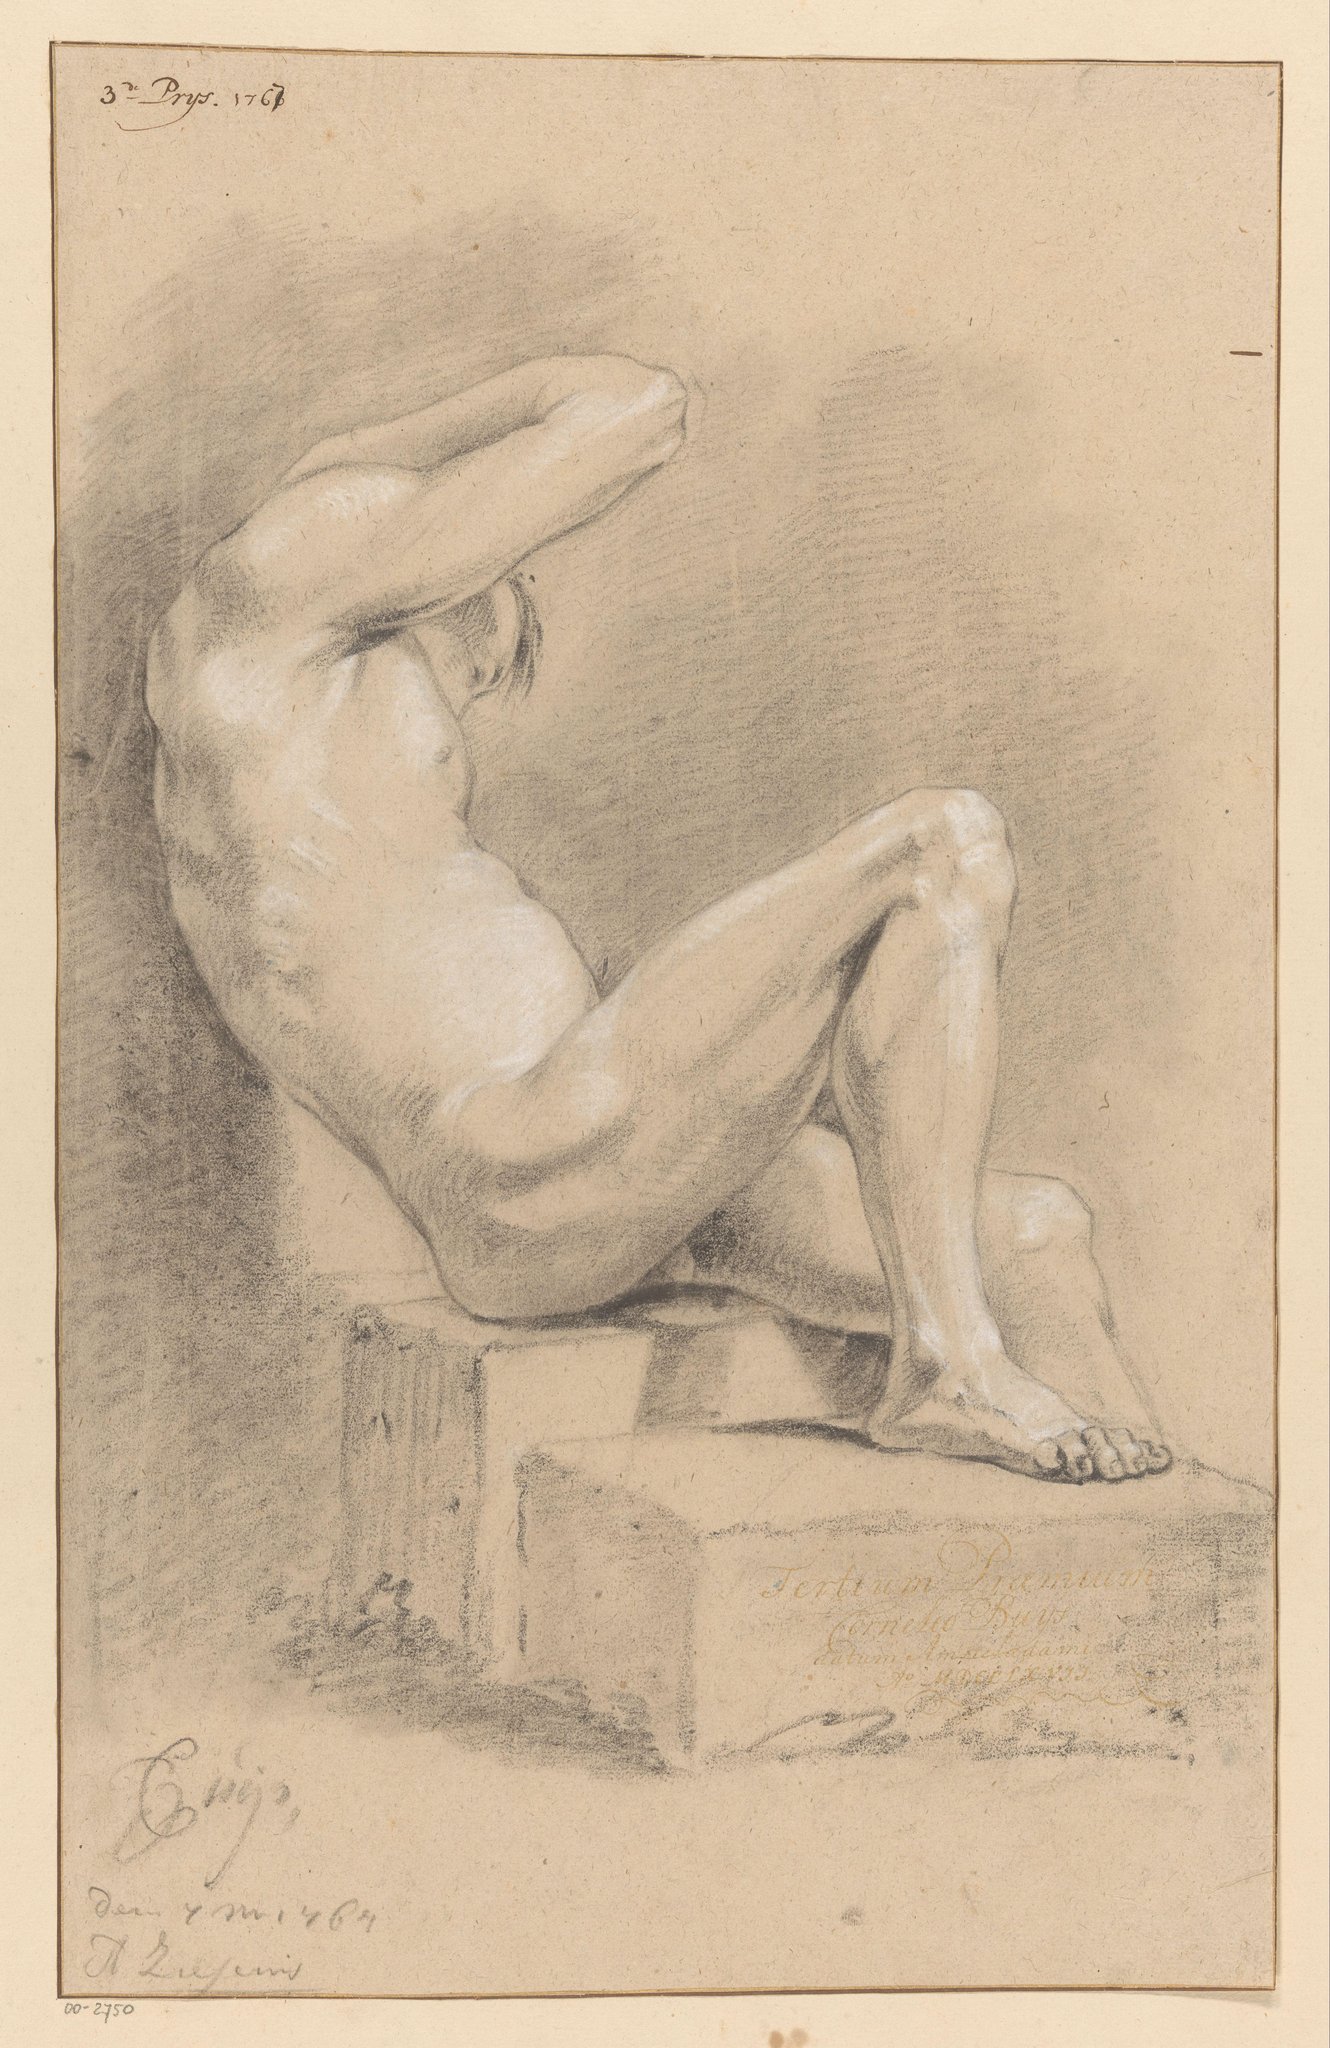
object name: drawing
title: Zittend mannelijk naakt, van opzij gezien (3e prijs 1767)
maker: cornelis buys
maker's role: draughtsman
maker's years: 1746-1826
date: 1767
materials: chalk, paper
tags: sitting figure (+ nude human being)